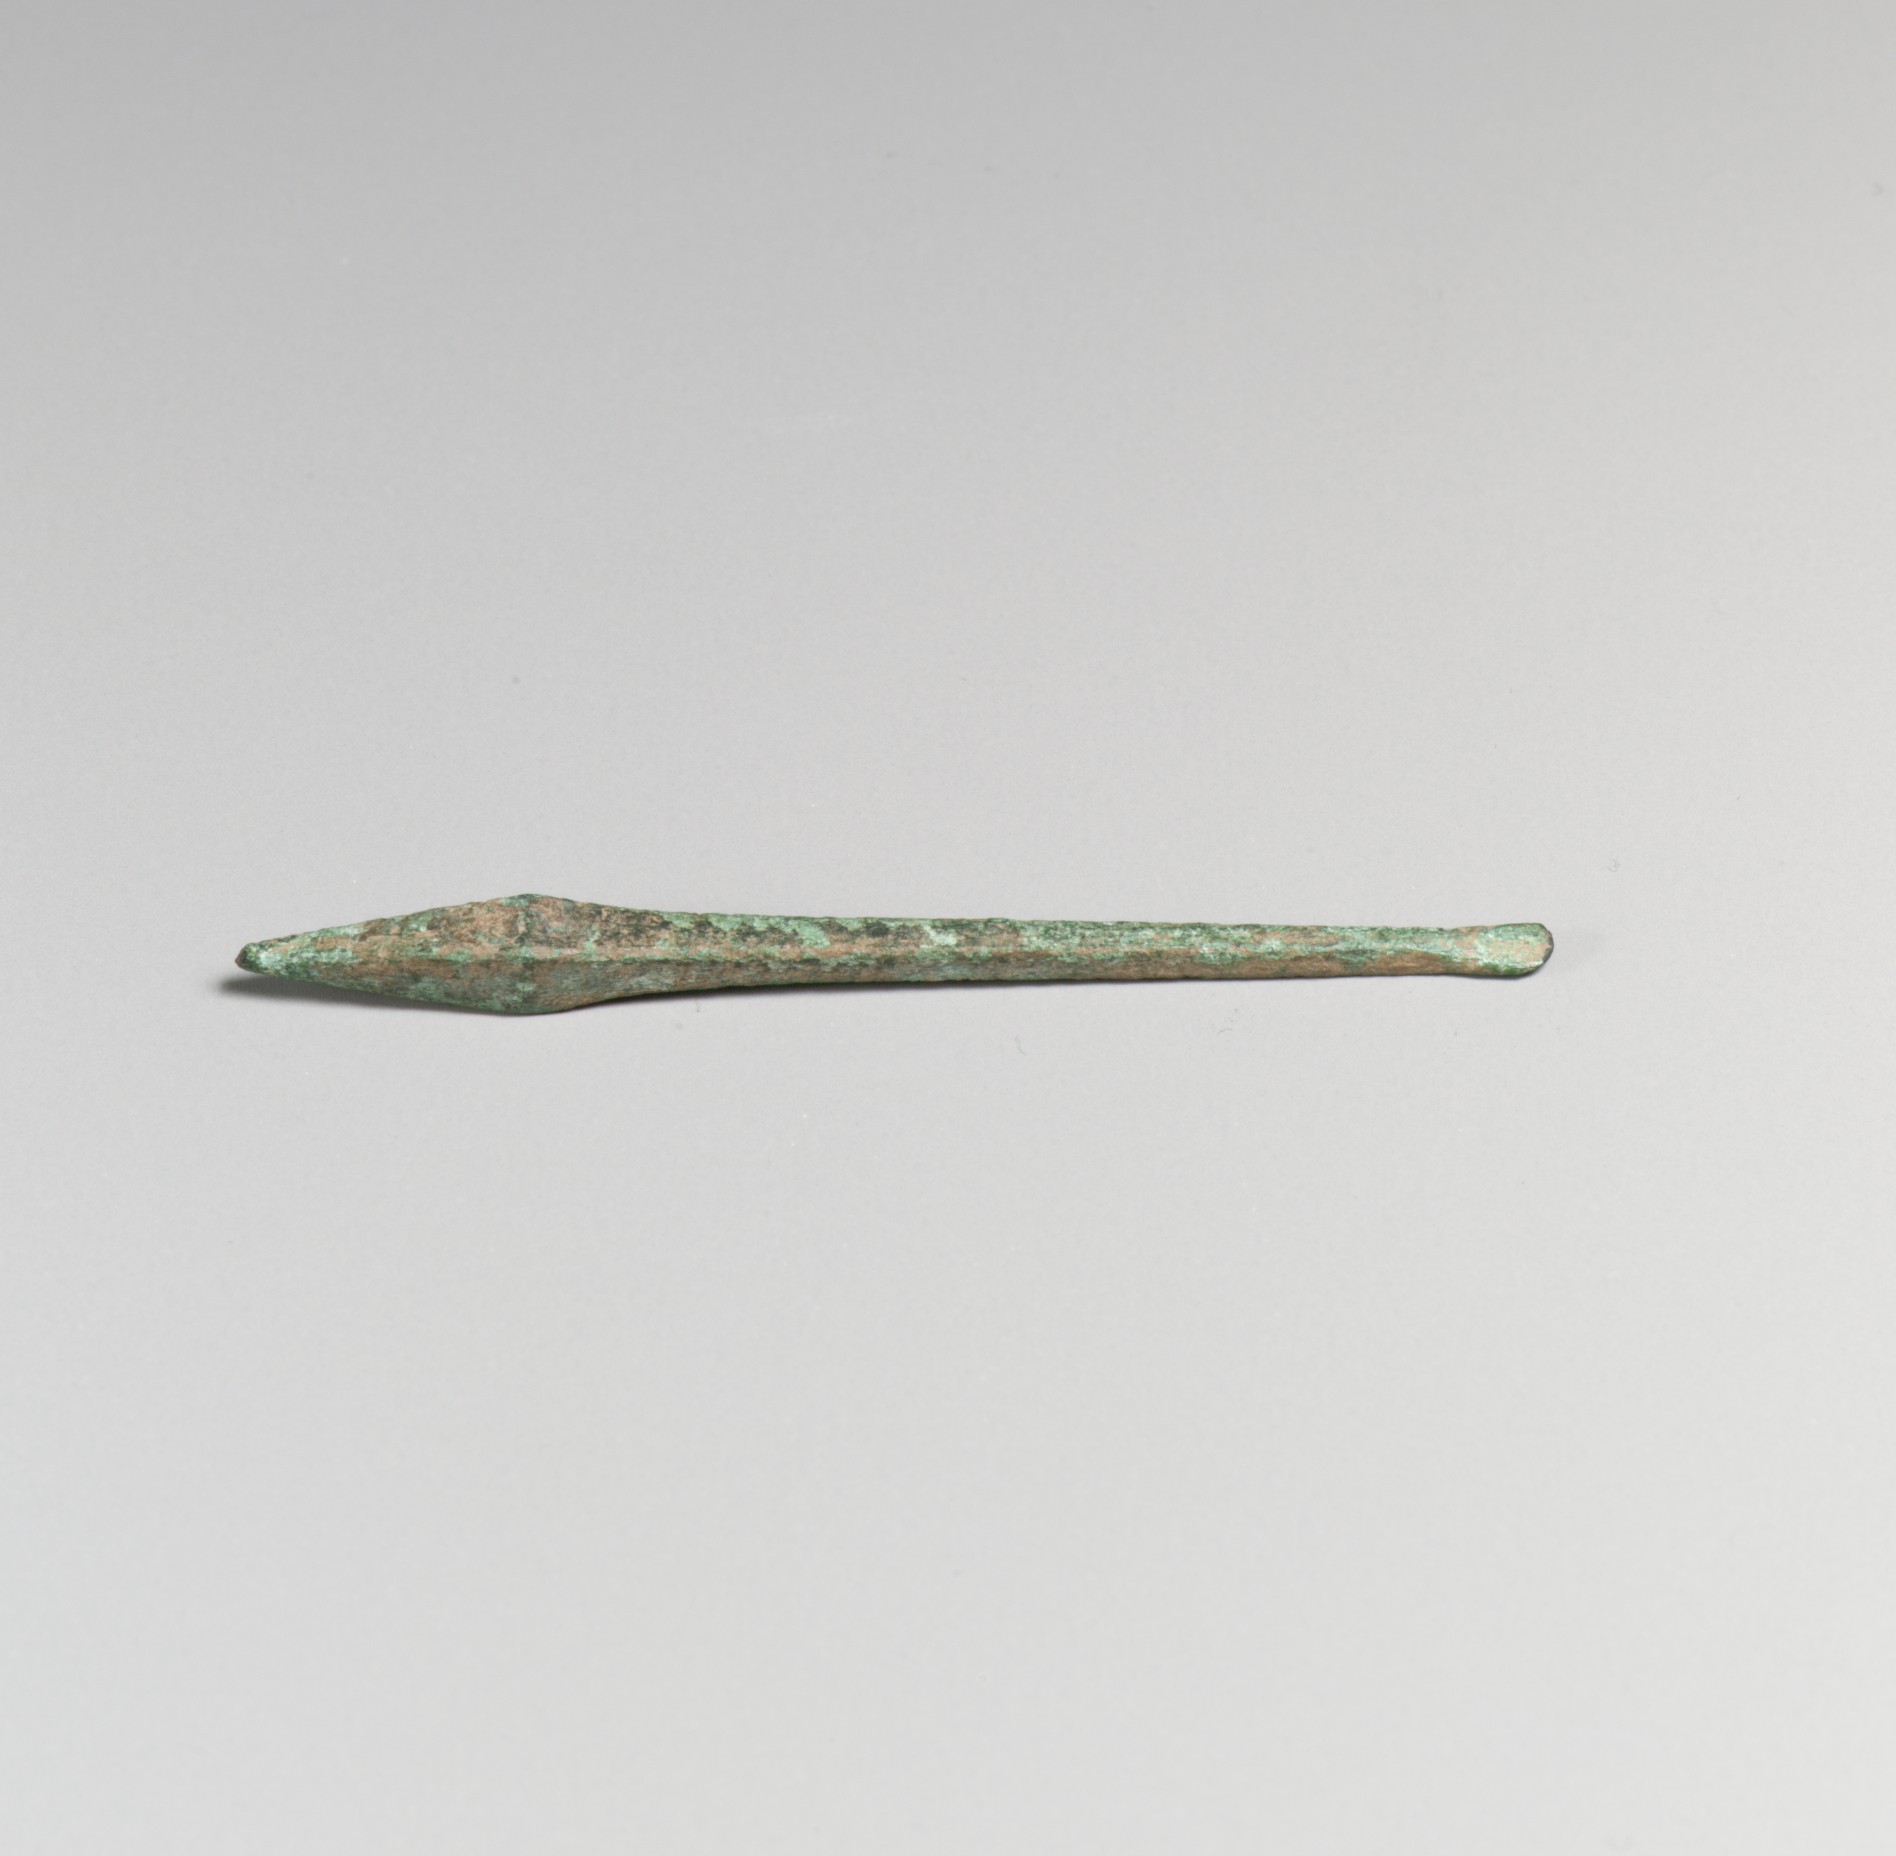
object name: arrowhead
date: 7000 BCE-330 CE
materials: bronze